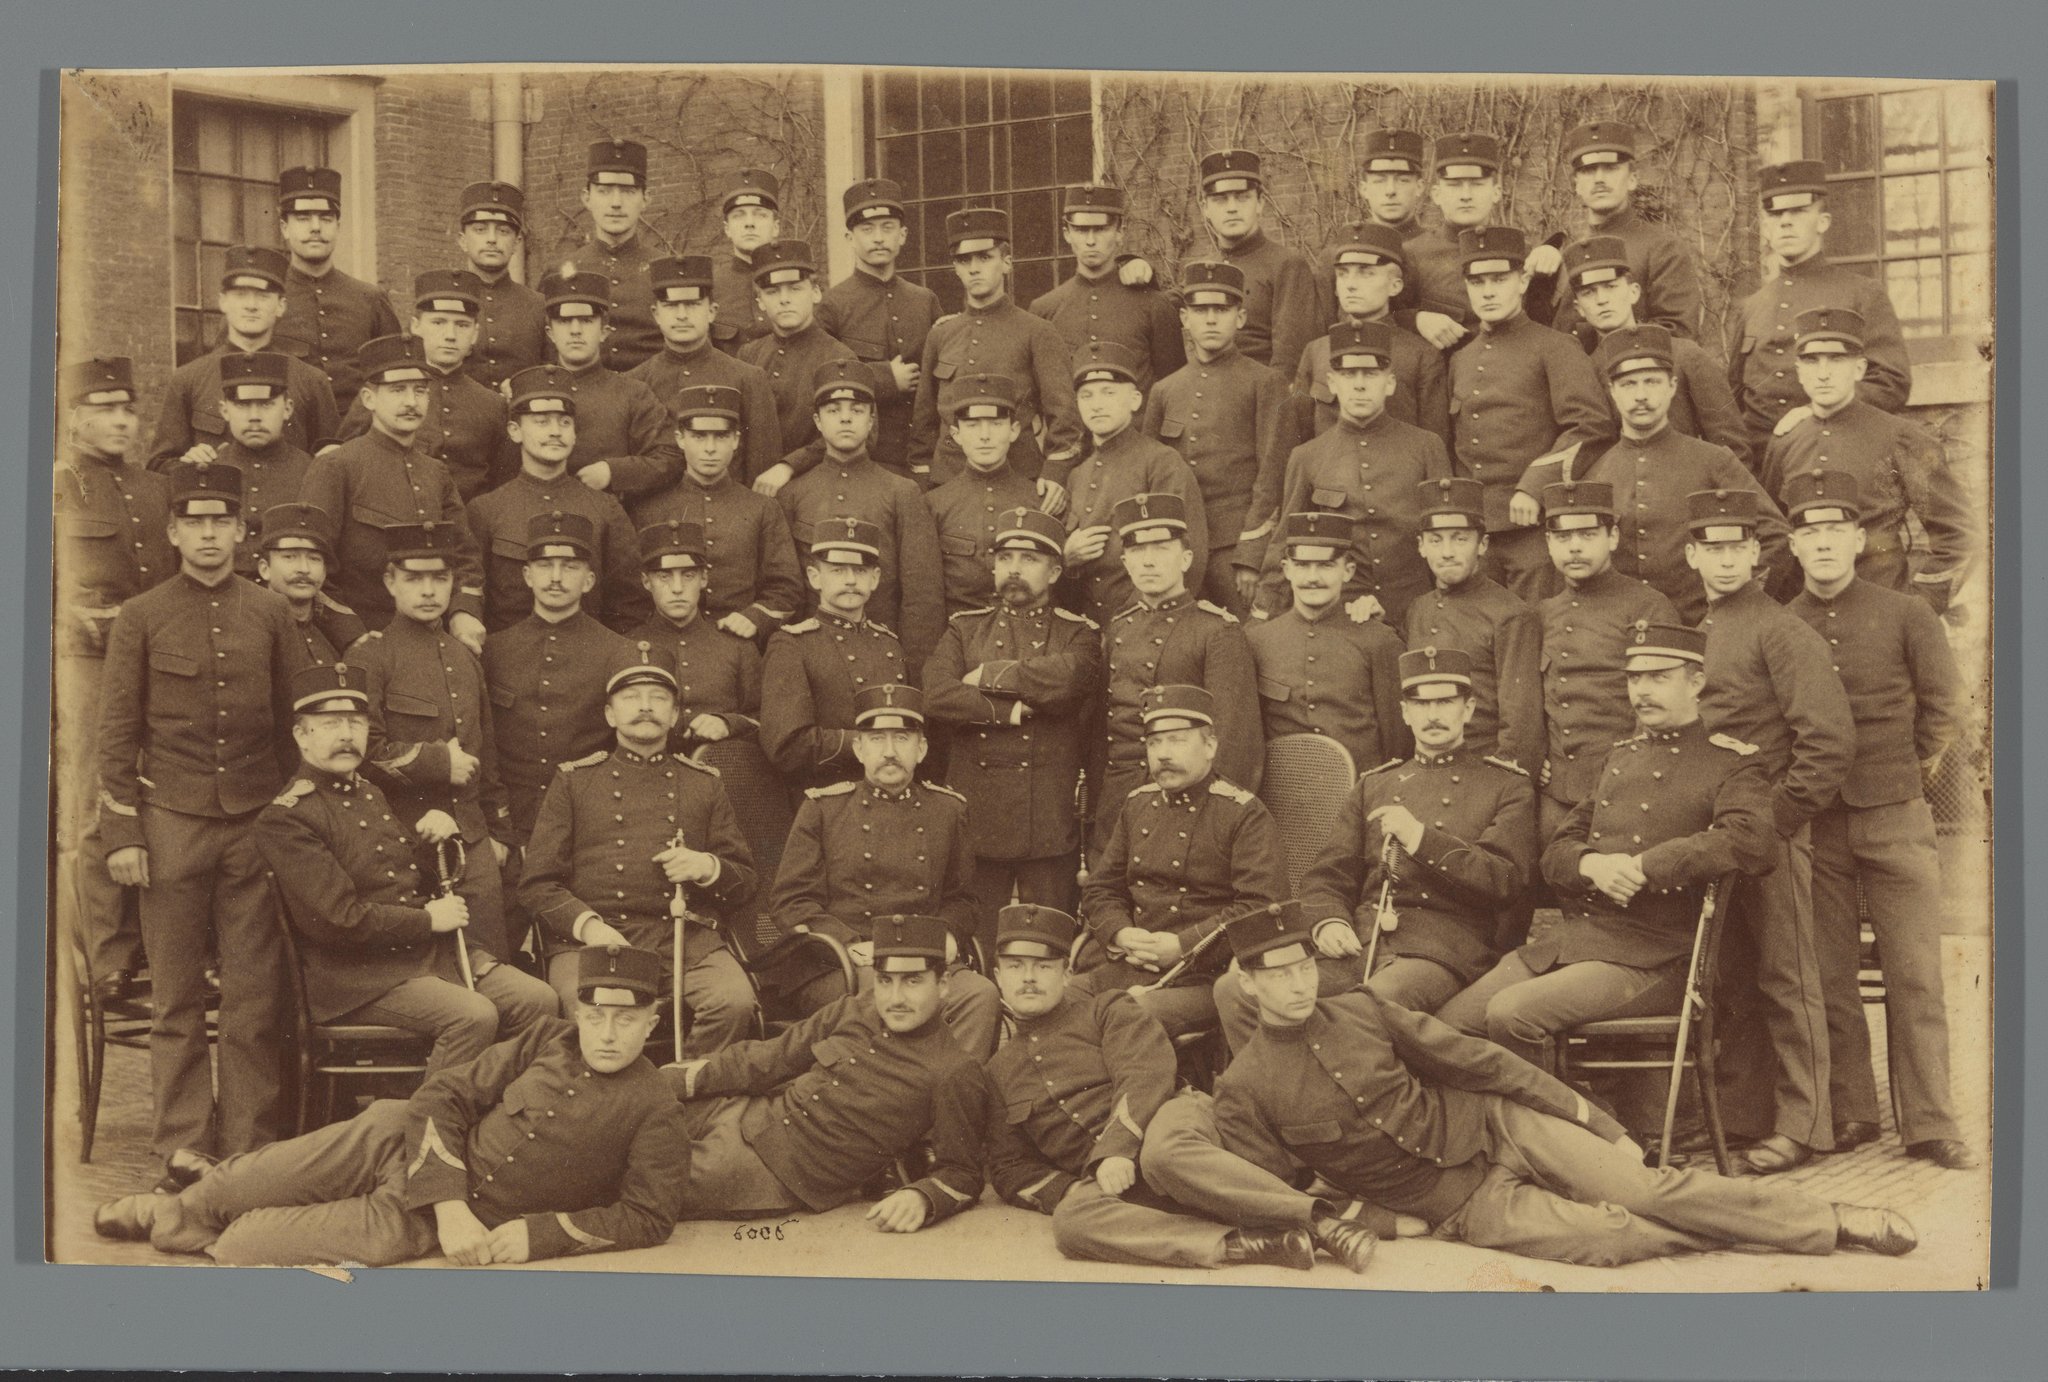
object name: photograph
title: Groepsportret van onbekende Nederlandse militairen, ten tijde van de Eerste Wereldoorlog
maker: Anonymous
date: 1914-1916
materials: paper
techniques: collodion silver print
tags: the soldier; the soldier's life, anonymous historical persons portrayed in a group, in a group-portrait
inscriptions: number: ‘5005’